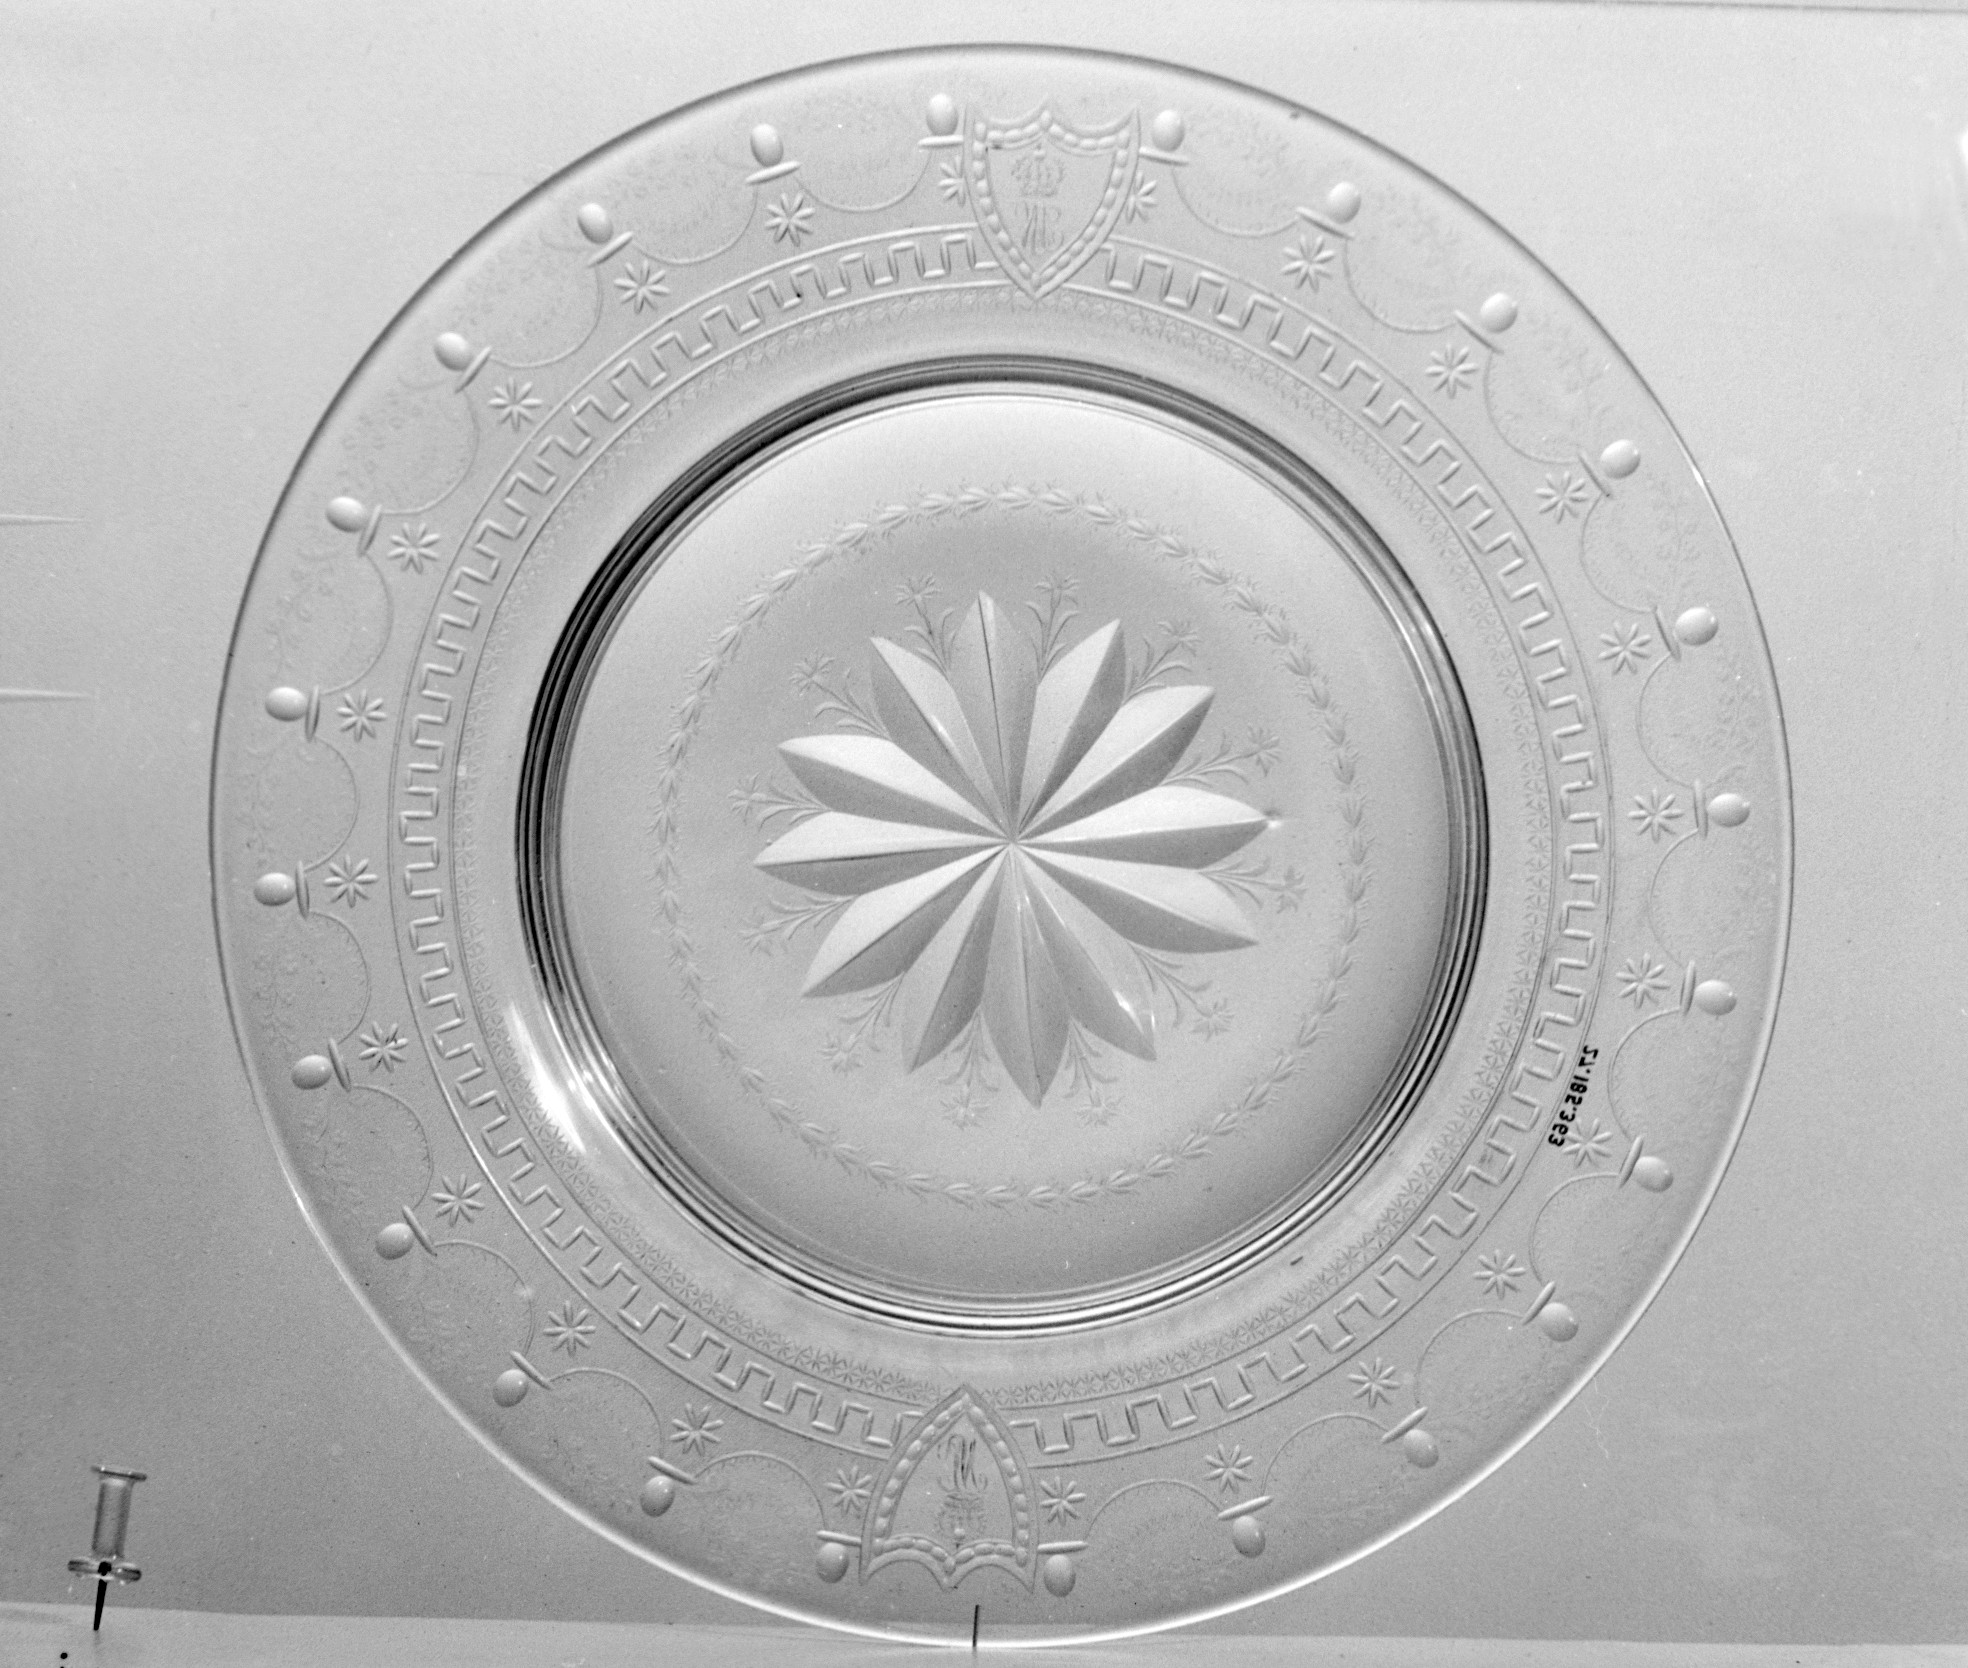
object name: cover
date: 1805-1809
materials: glass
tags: flowers